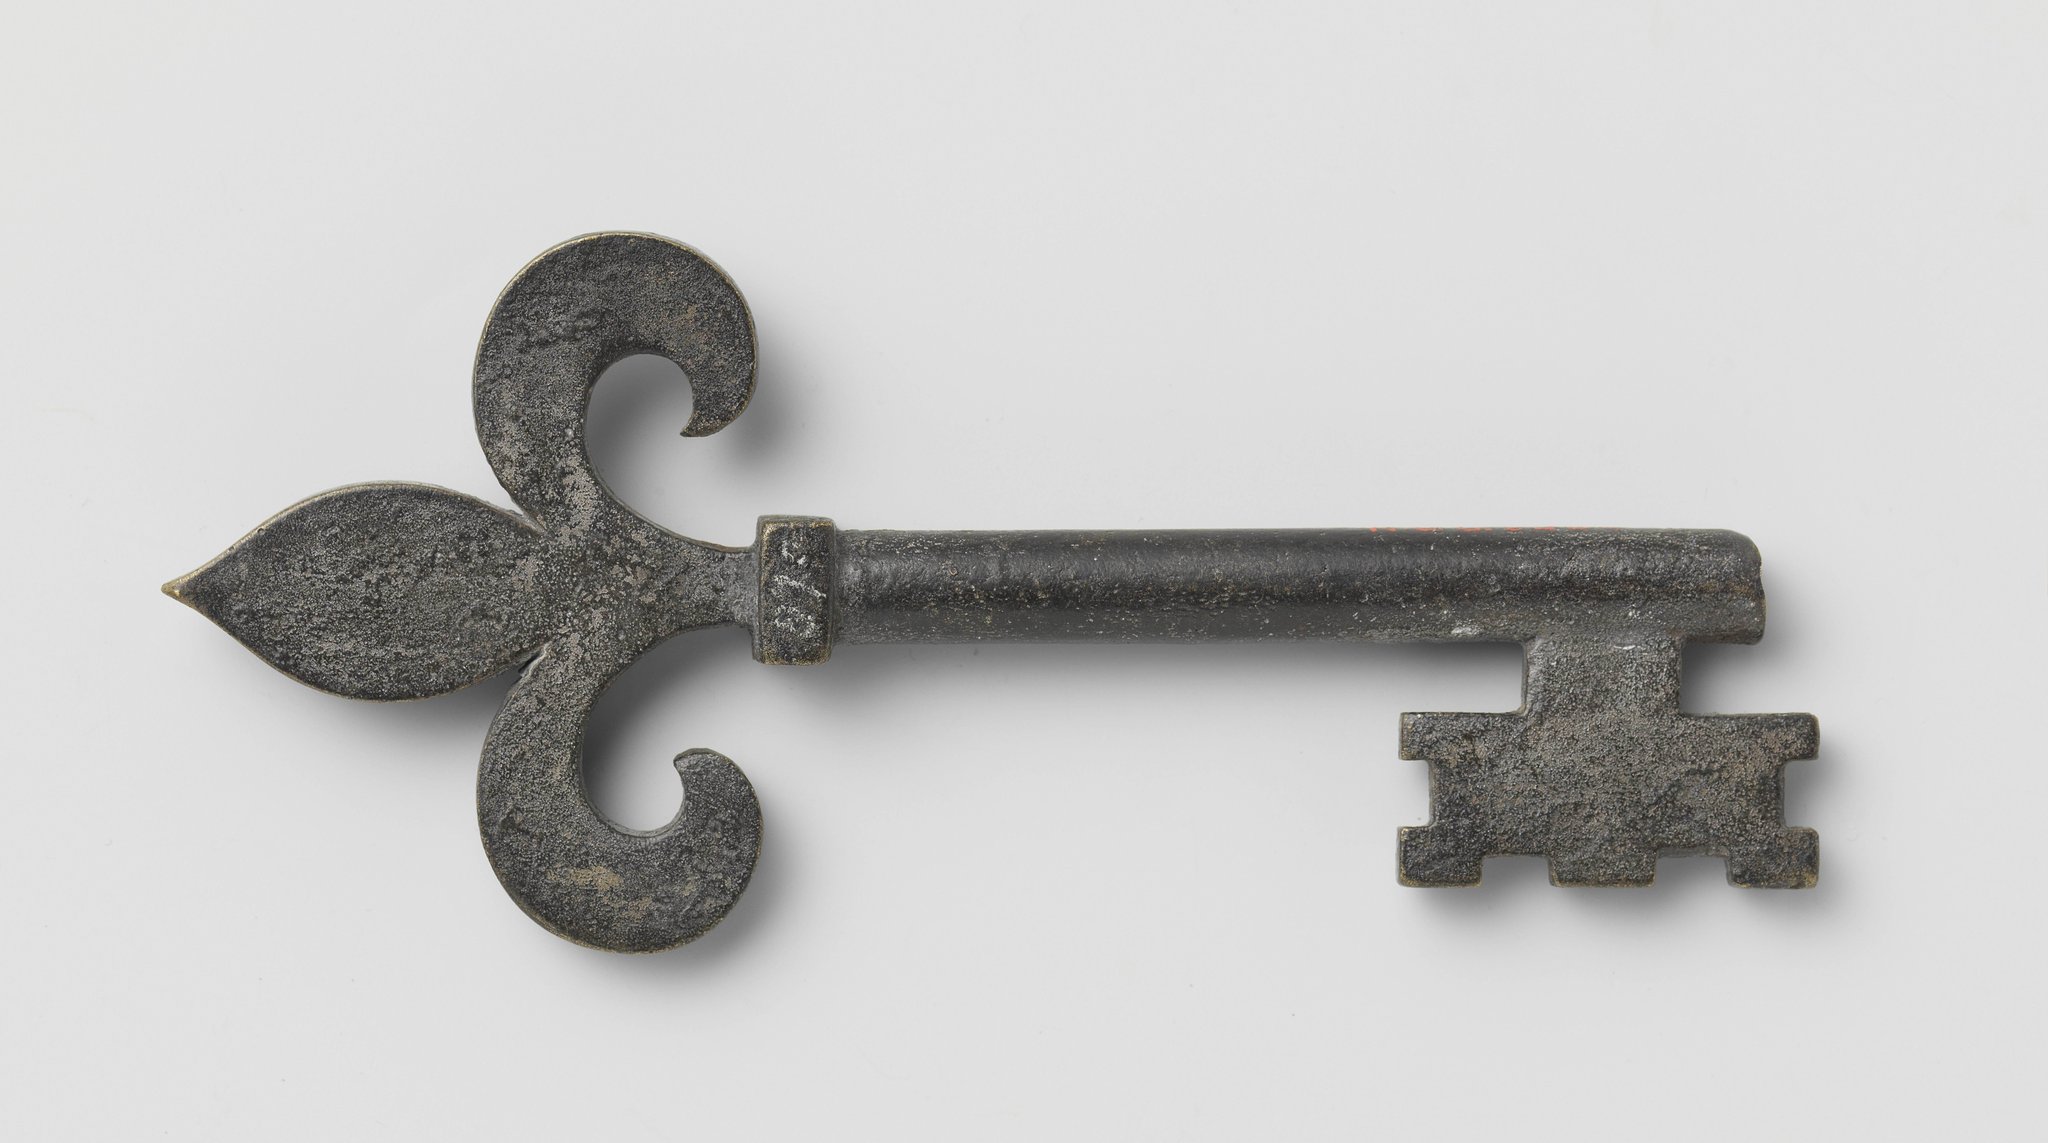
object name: pipe key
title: Key with barrel shank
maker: Anonymous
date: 1800-1900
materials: bronze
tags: fleur-de-lis ~ ornament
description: Pijpsleutel met greep in de vorm van een lelie op een vierkant blokje boven de schacht geplaatst.